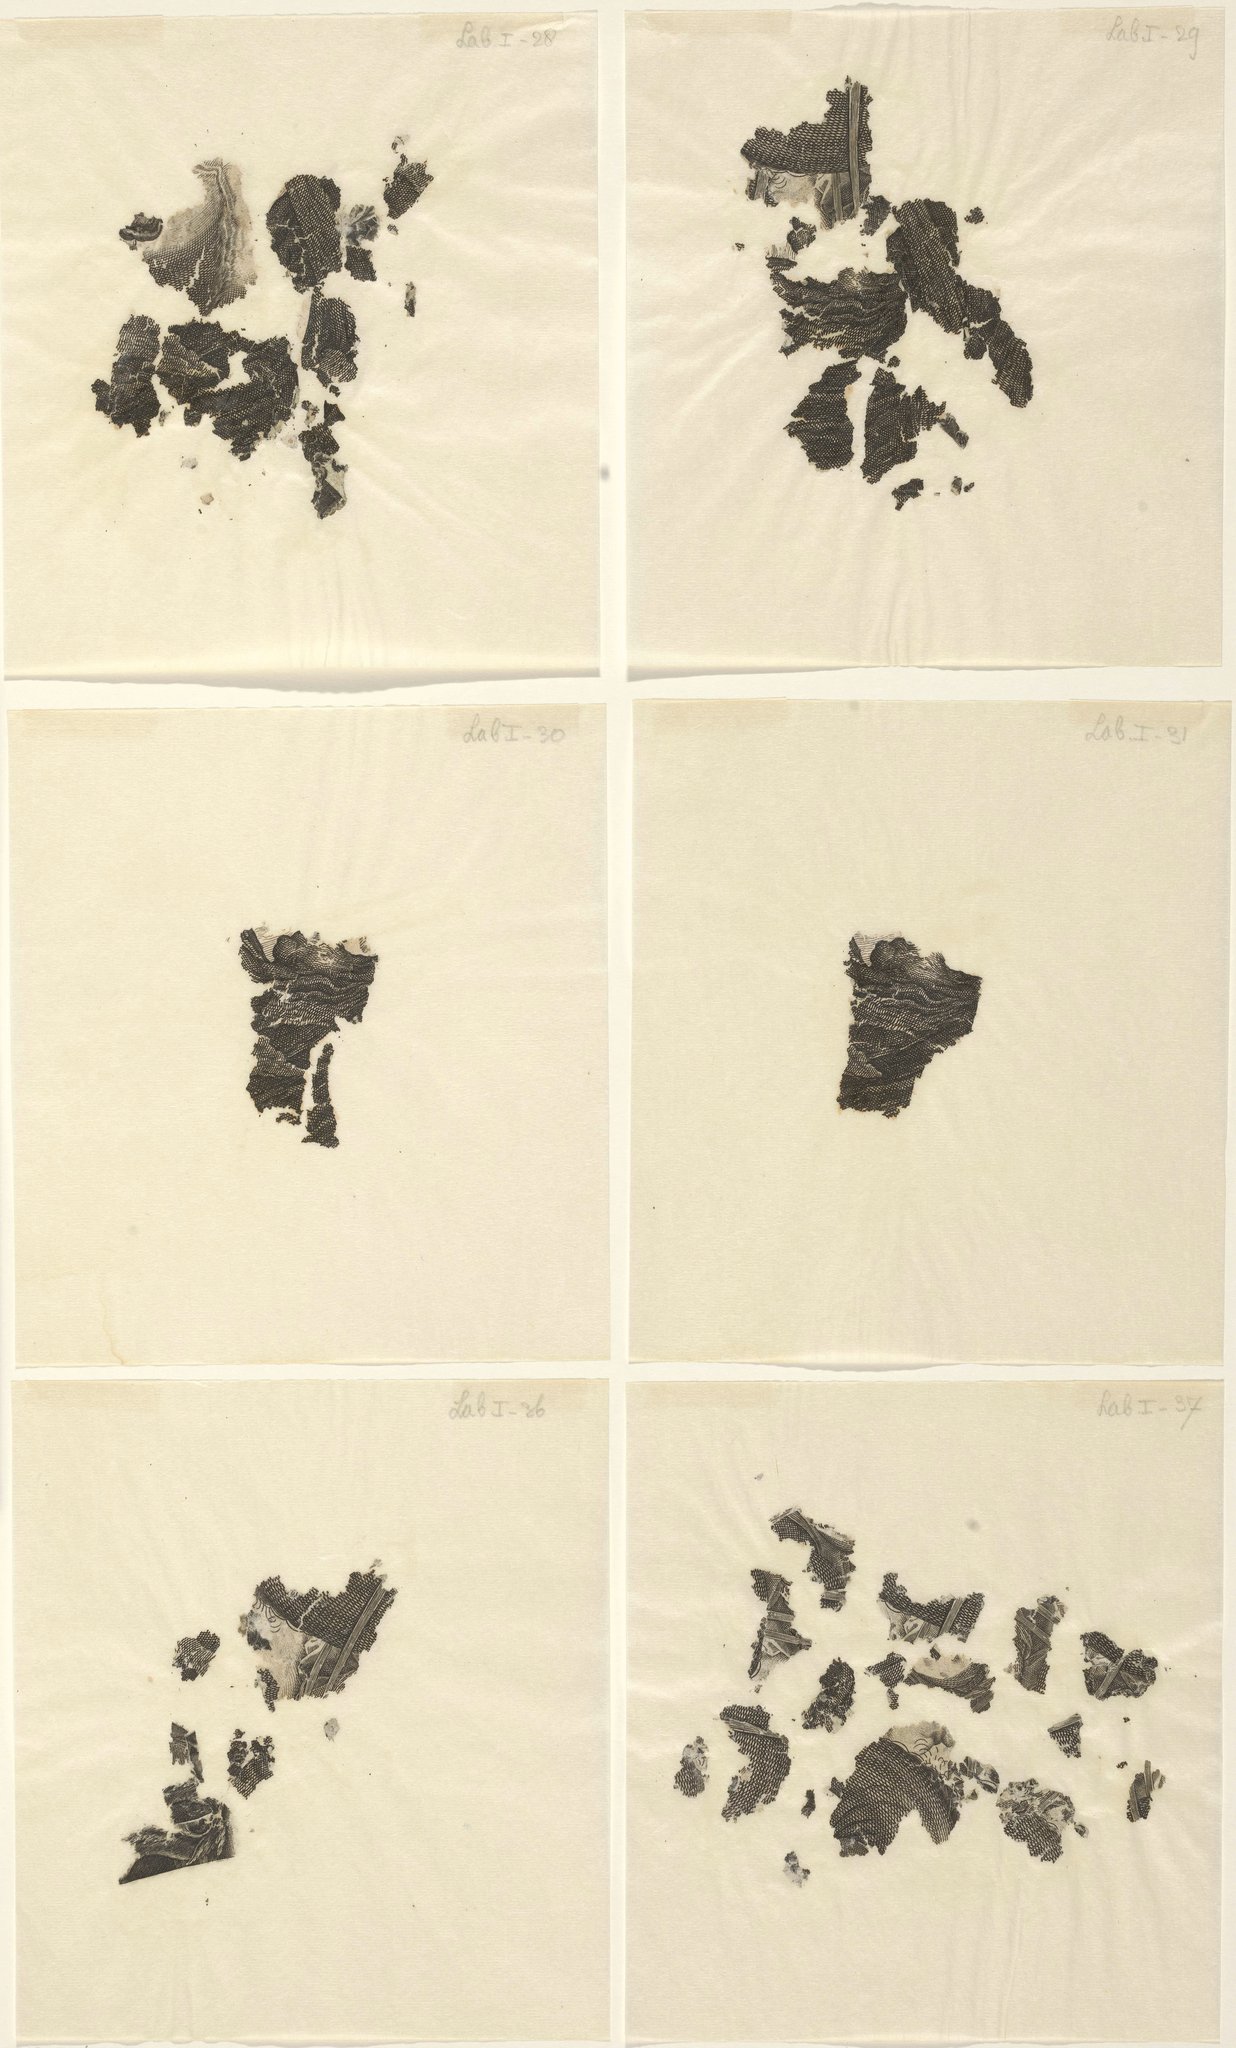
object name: print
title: Losse fragmenten van prenten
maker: Anonymous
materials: paper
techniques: engraving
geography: netherlands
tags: reis van barendsz en van heemskerck in 1596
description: De prenten in de Nova Zembla collectie zijn tijdens een expeditie van Willem Barendsz en Jacob van Heemskerk in 1596-1597 noodgedwongen in het winterkamp, het ‘Behouden Huis’, op het eiland achtergelaten. De prenten waren in één of meerdere stapels als handelswaar meegenomen vanuit Amsterdam. Bijna drie eeuwen later, in 1871, keerde de Noor Elling Carlsen terug naar Nova Zembla en vond daar de restanten van het ‘Behouden Huis, inclusief een groot deel van de inventaris. Een deel van de prenten, in de vorm van aaneengekoekte kluiten, werd toen ook teruggevonden. De papierkluiten waren soms op meerdere plekken gebroken. Tussen 1975-1979 zijn de prenten van elkaar gescheiden. Dit leverde in totaal ca. 1000 fragmenten van ca. 400 afdrukken van ca. 150 verschillende prenten op. Voor zover mogelijk zijn de fragmenten samengevoegd en zijn de prenten gereconstrueerd.